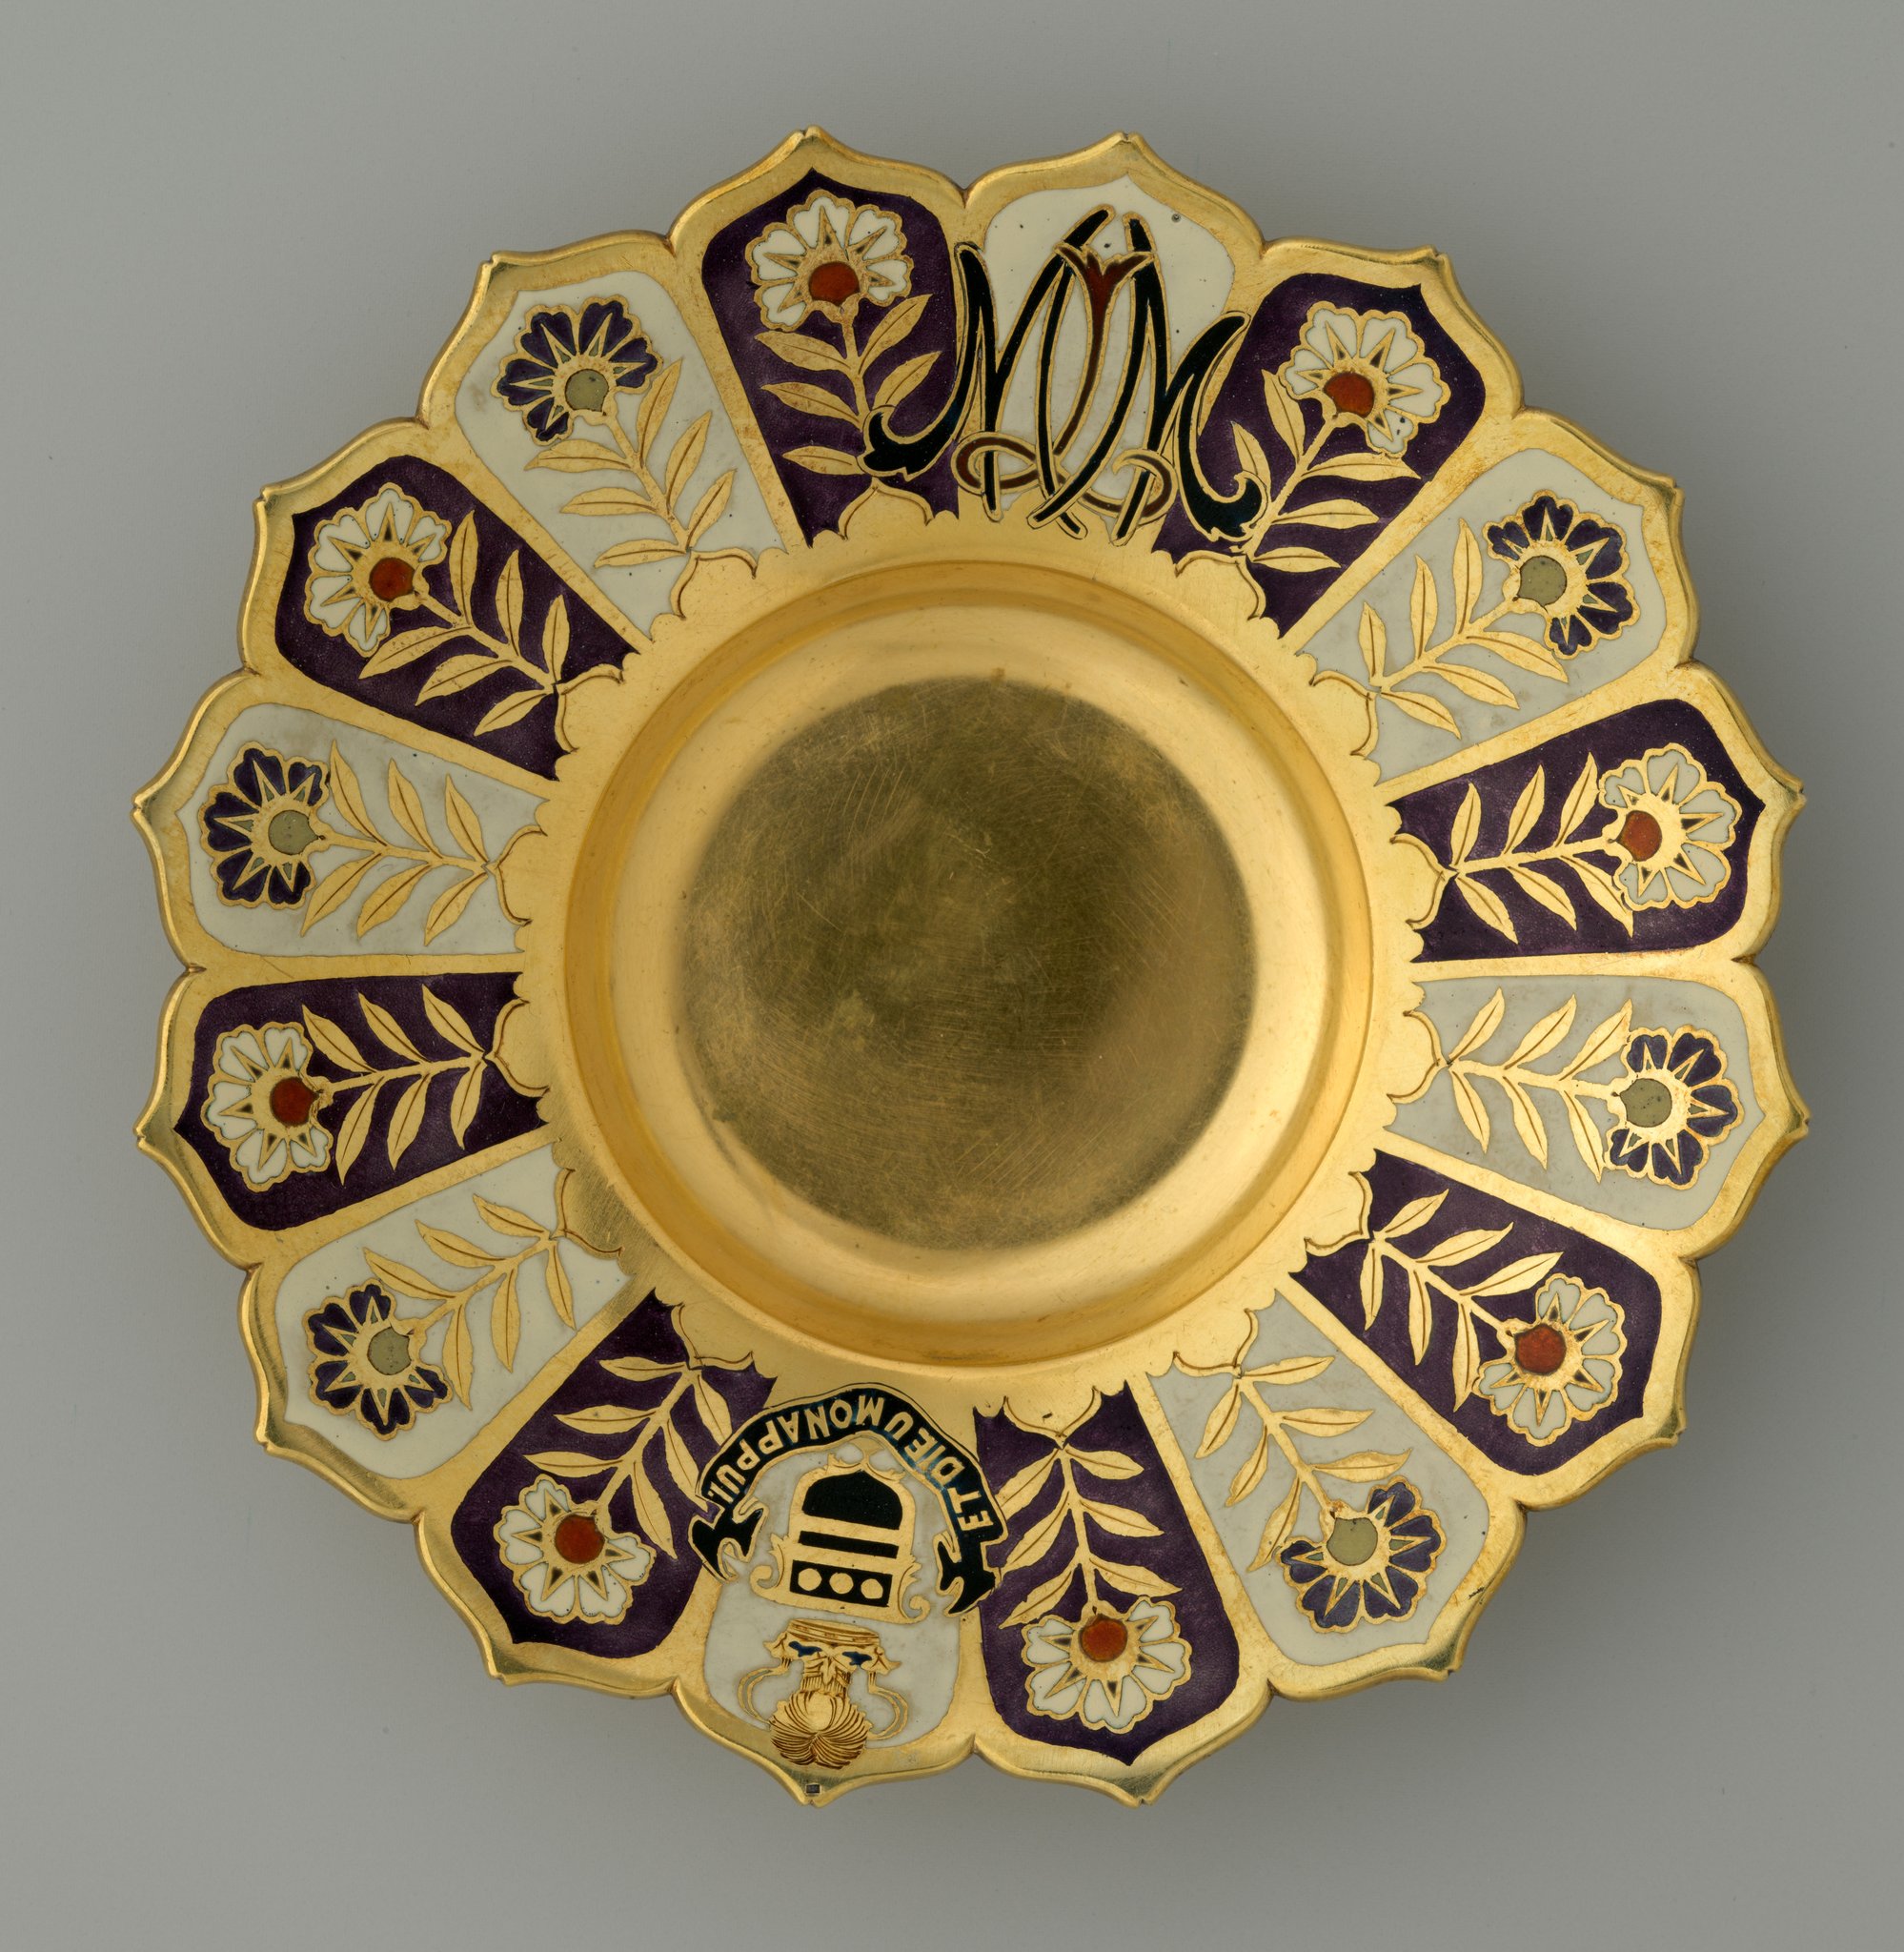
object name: saucer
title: Saucer from the Mackay Service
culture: american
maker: tiffany & co.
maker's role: maker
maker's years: 1837-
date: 1878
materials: enamel, silver gilt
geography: united states